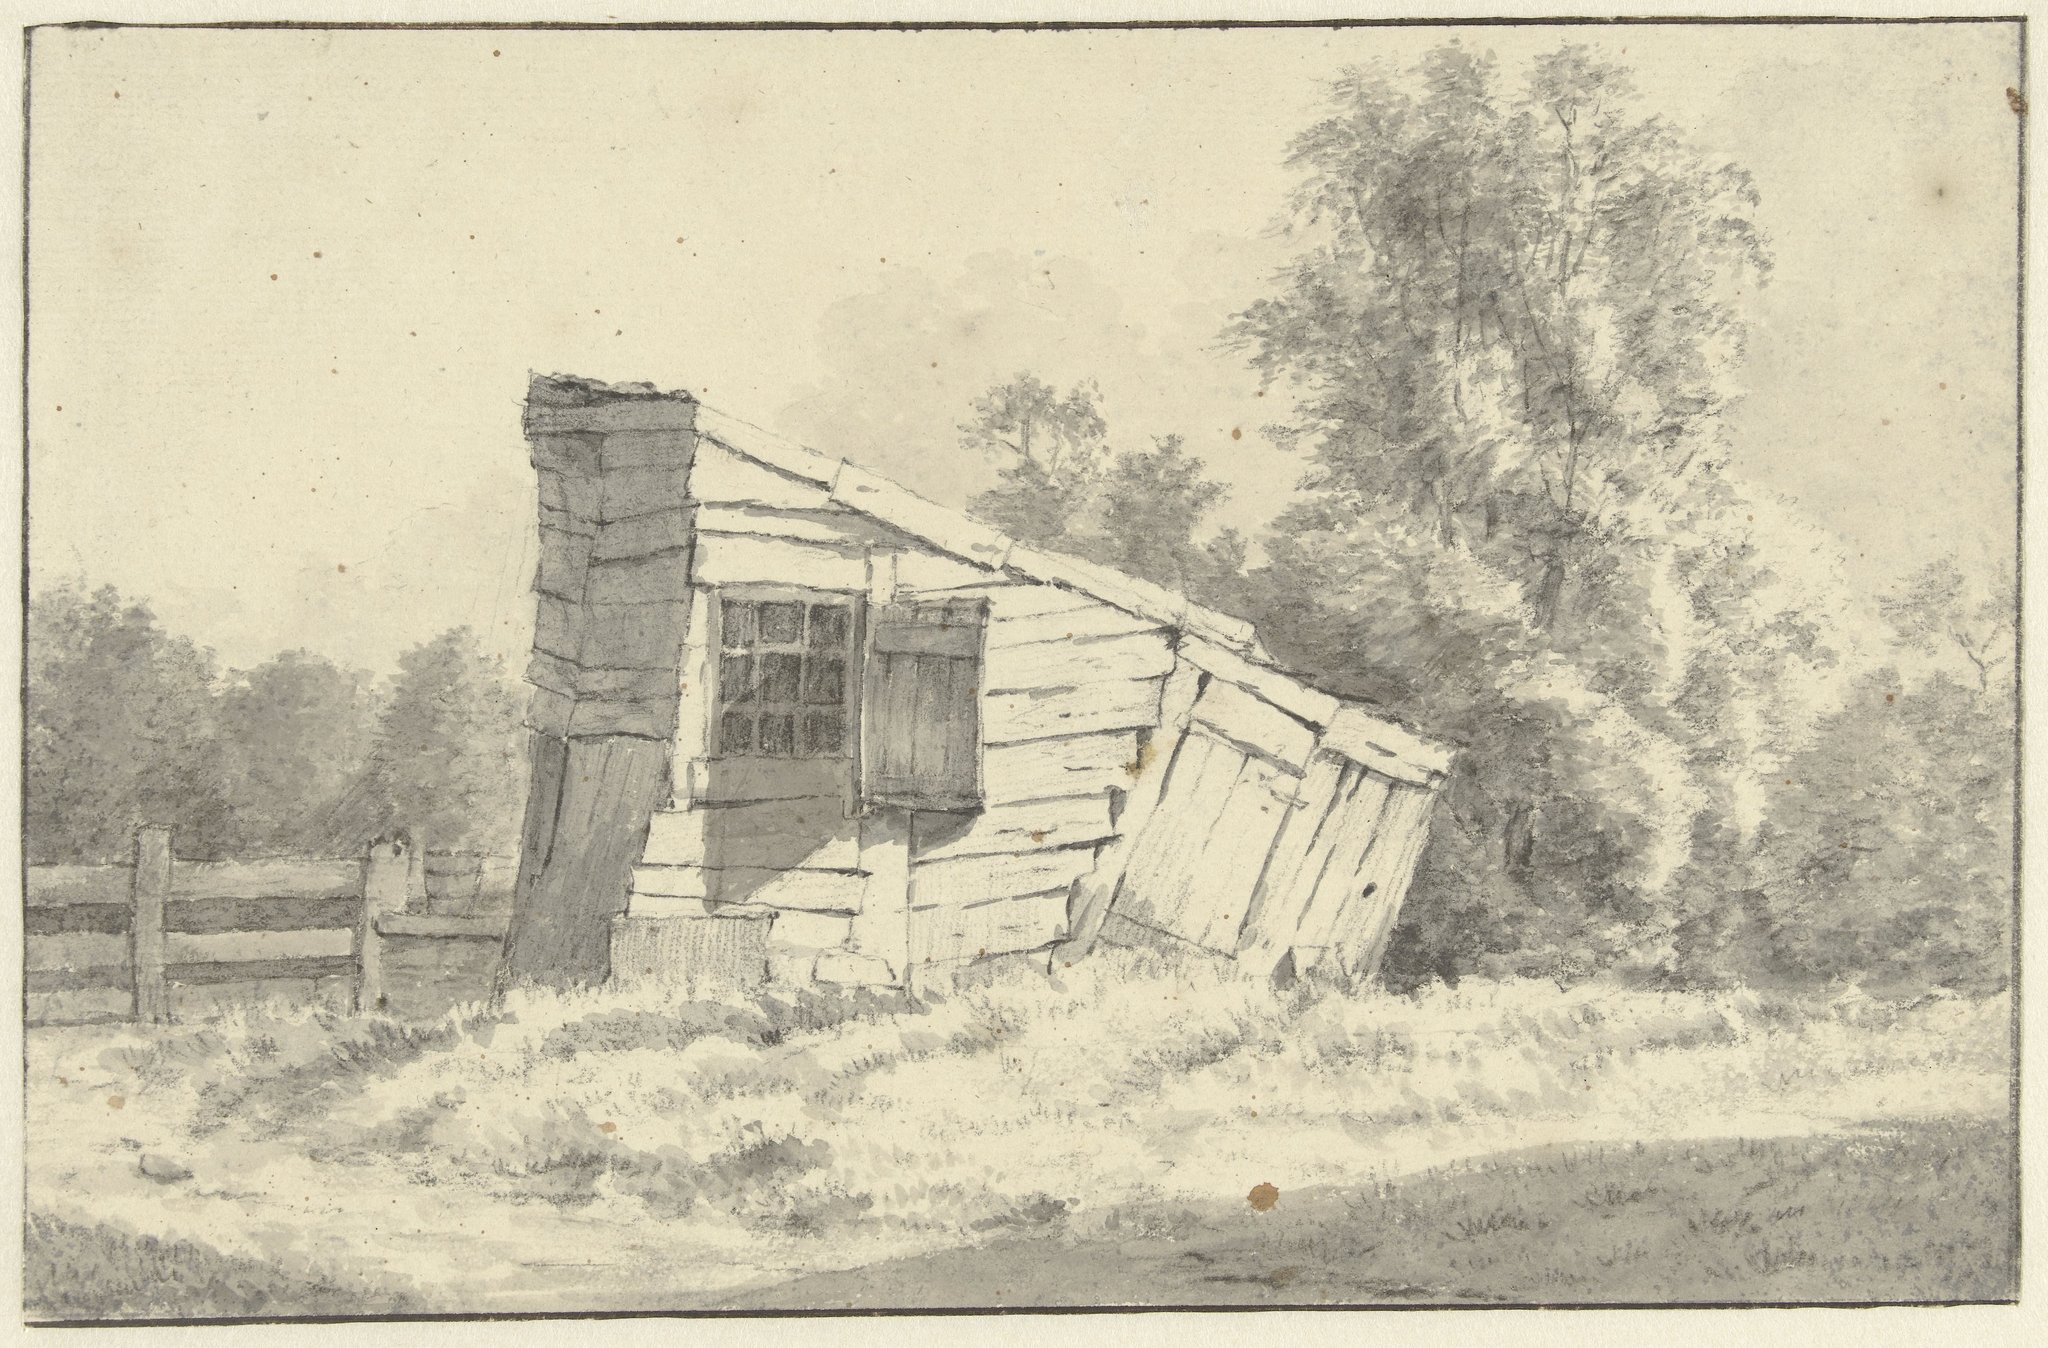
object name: drawing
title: Hut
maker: Anonymous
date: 1700-1800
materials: chalk, paper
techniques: brush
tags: hut, cabin, lodge